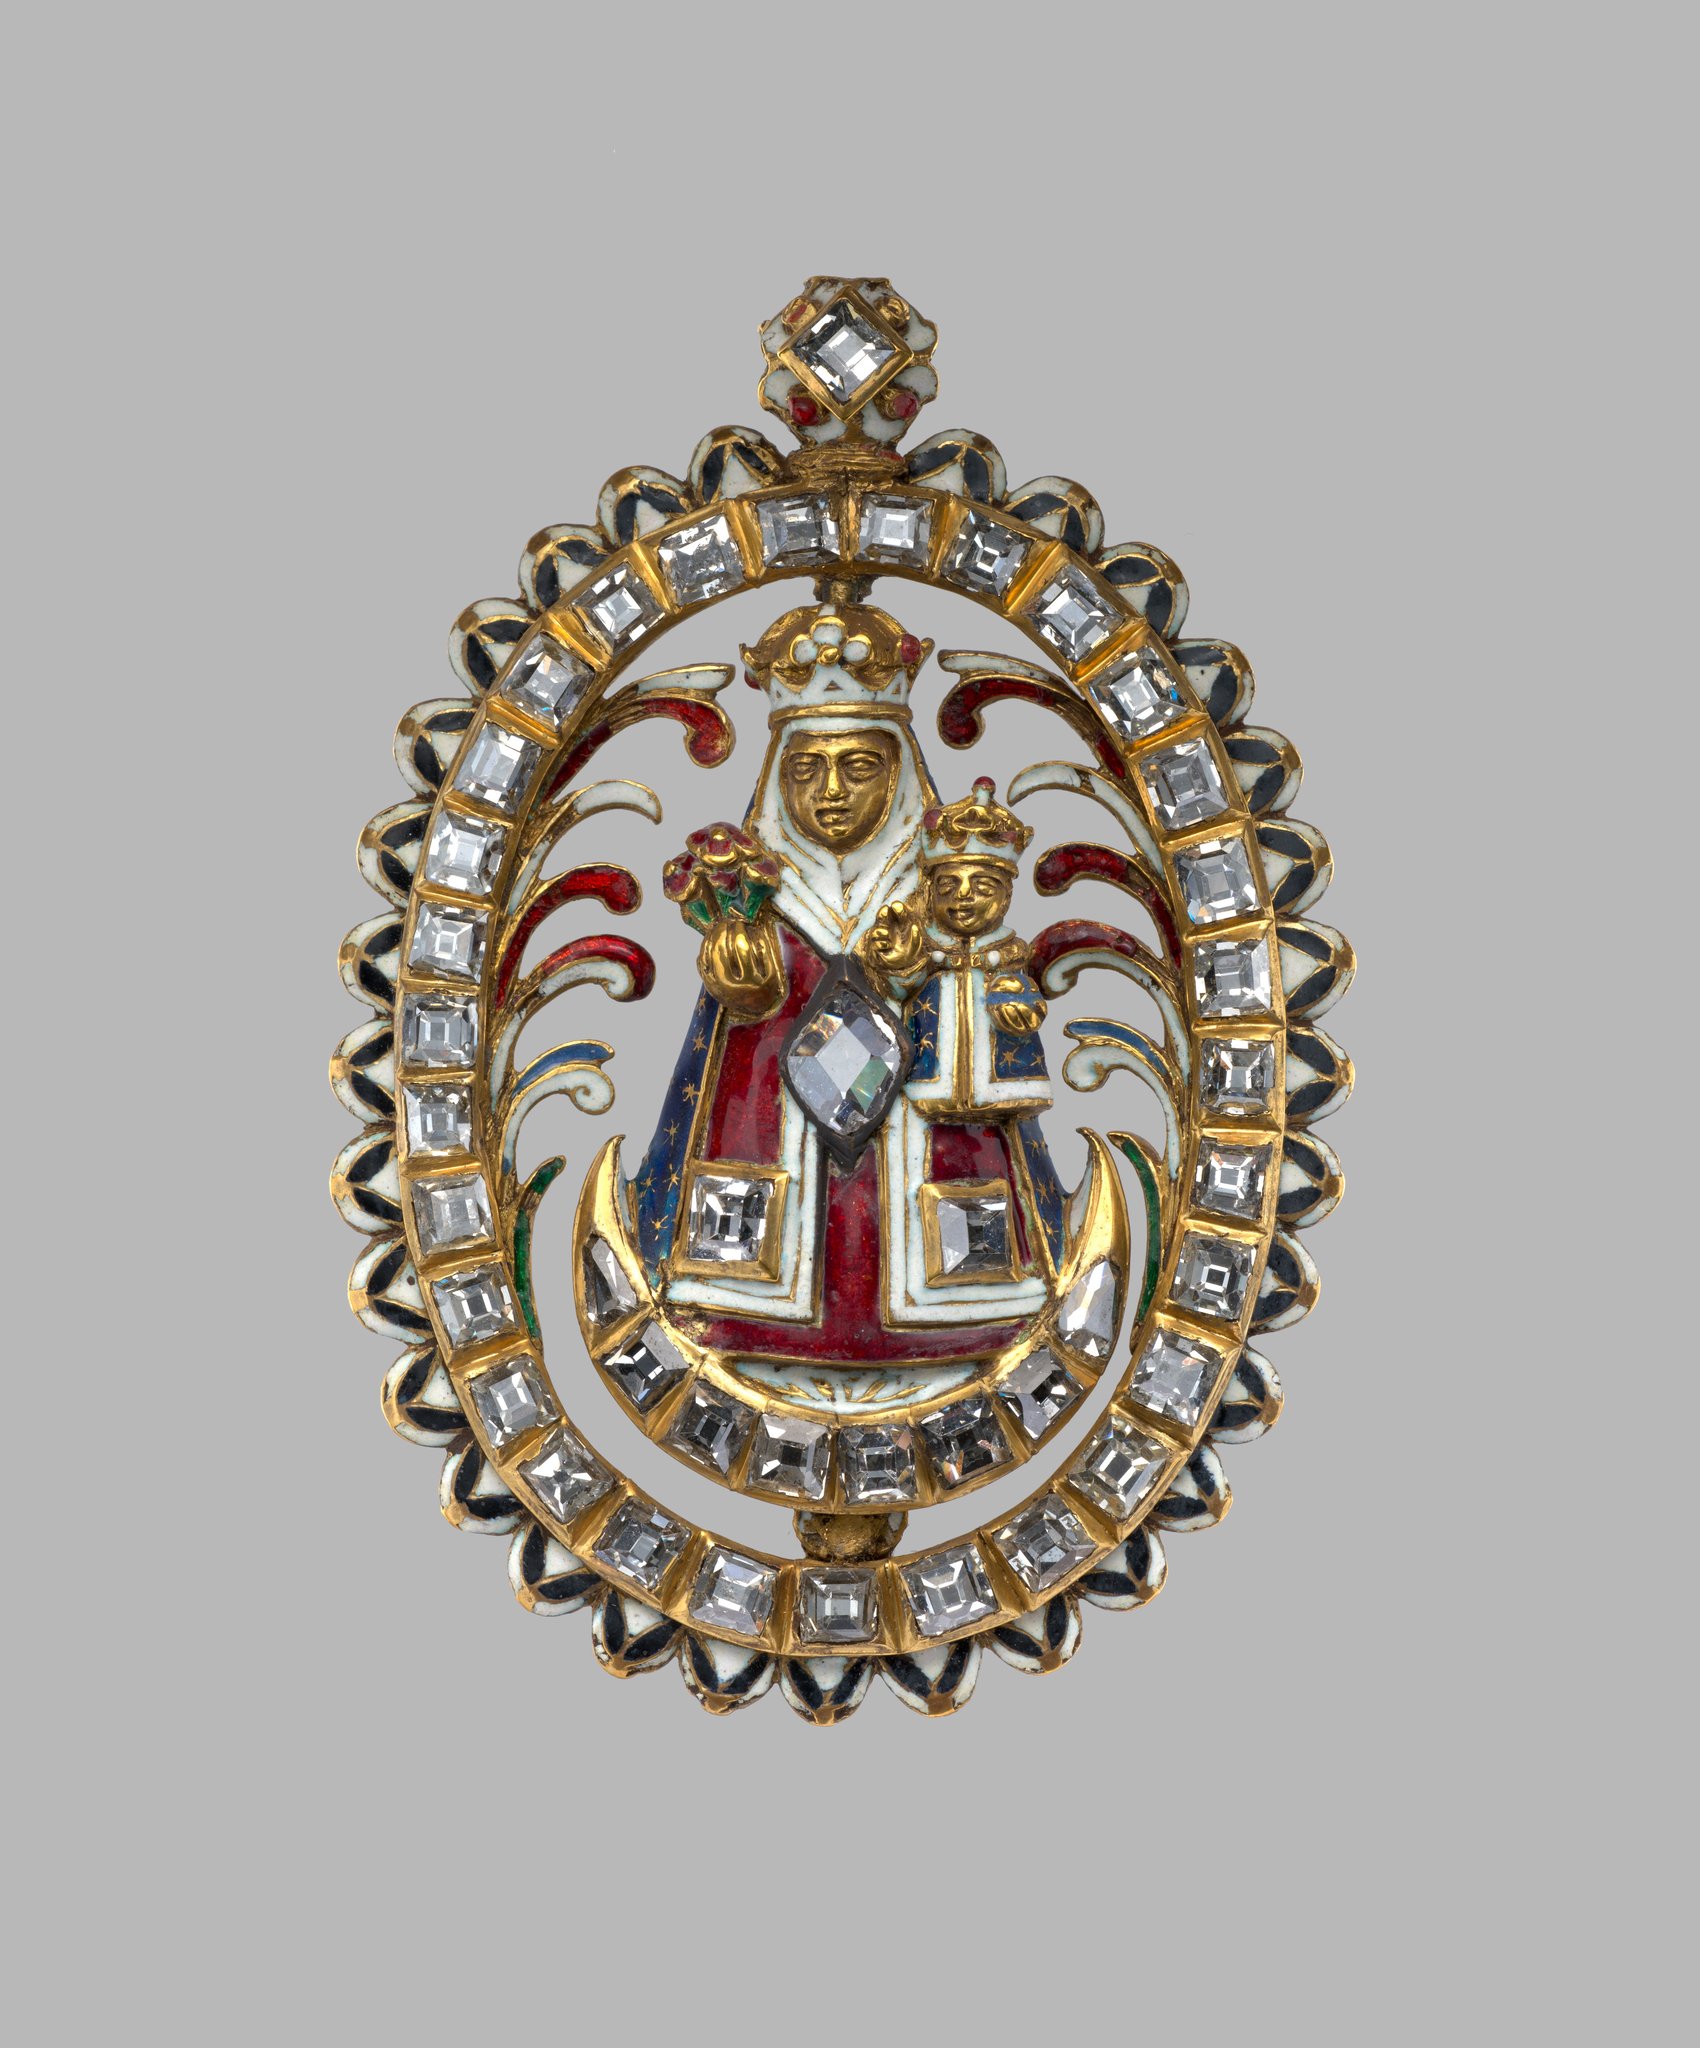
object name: pendant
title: Pendant with the Virgin and Child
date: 1601-1650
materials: diamond, gold, gemstone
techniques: enamel